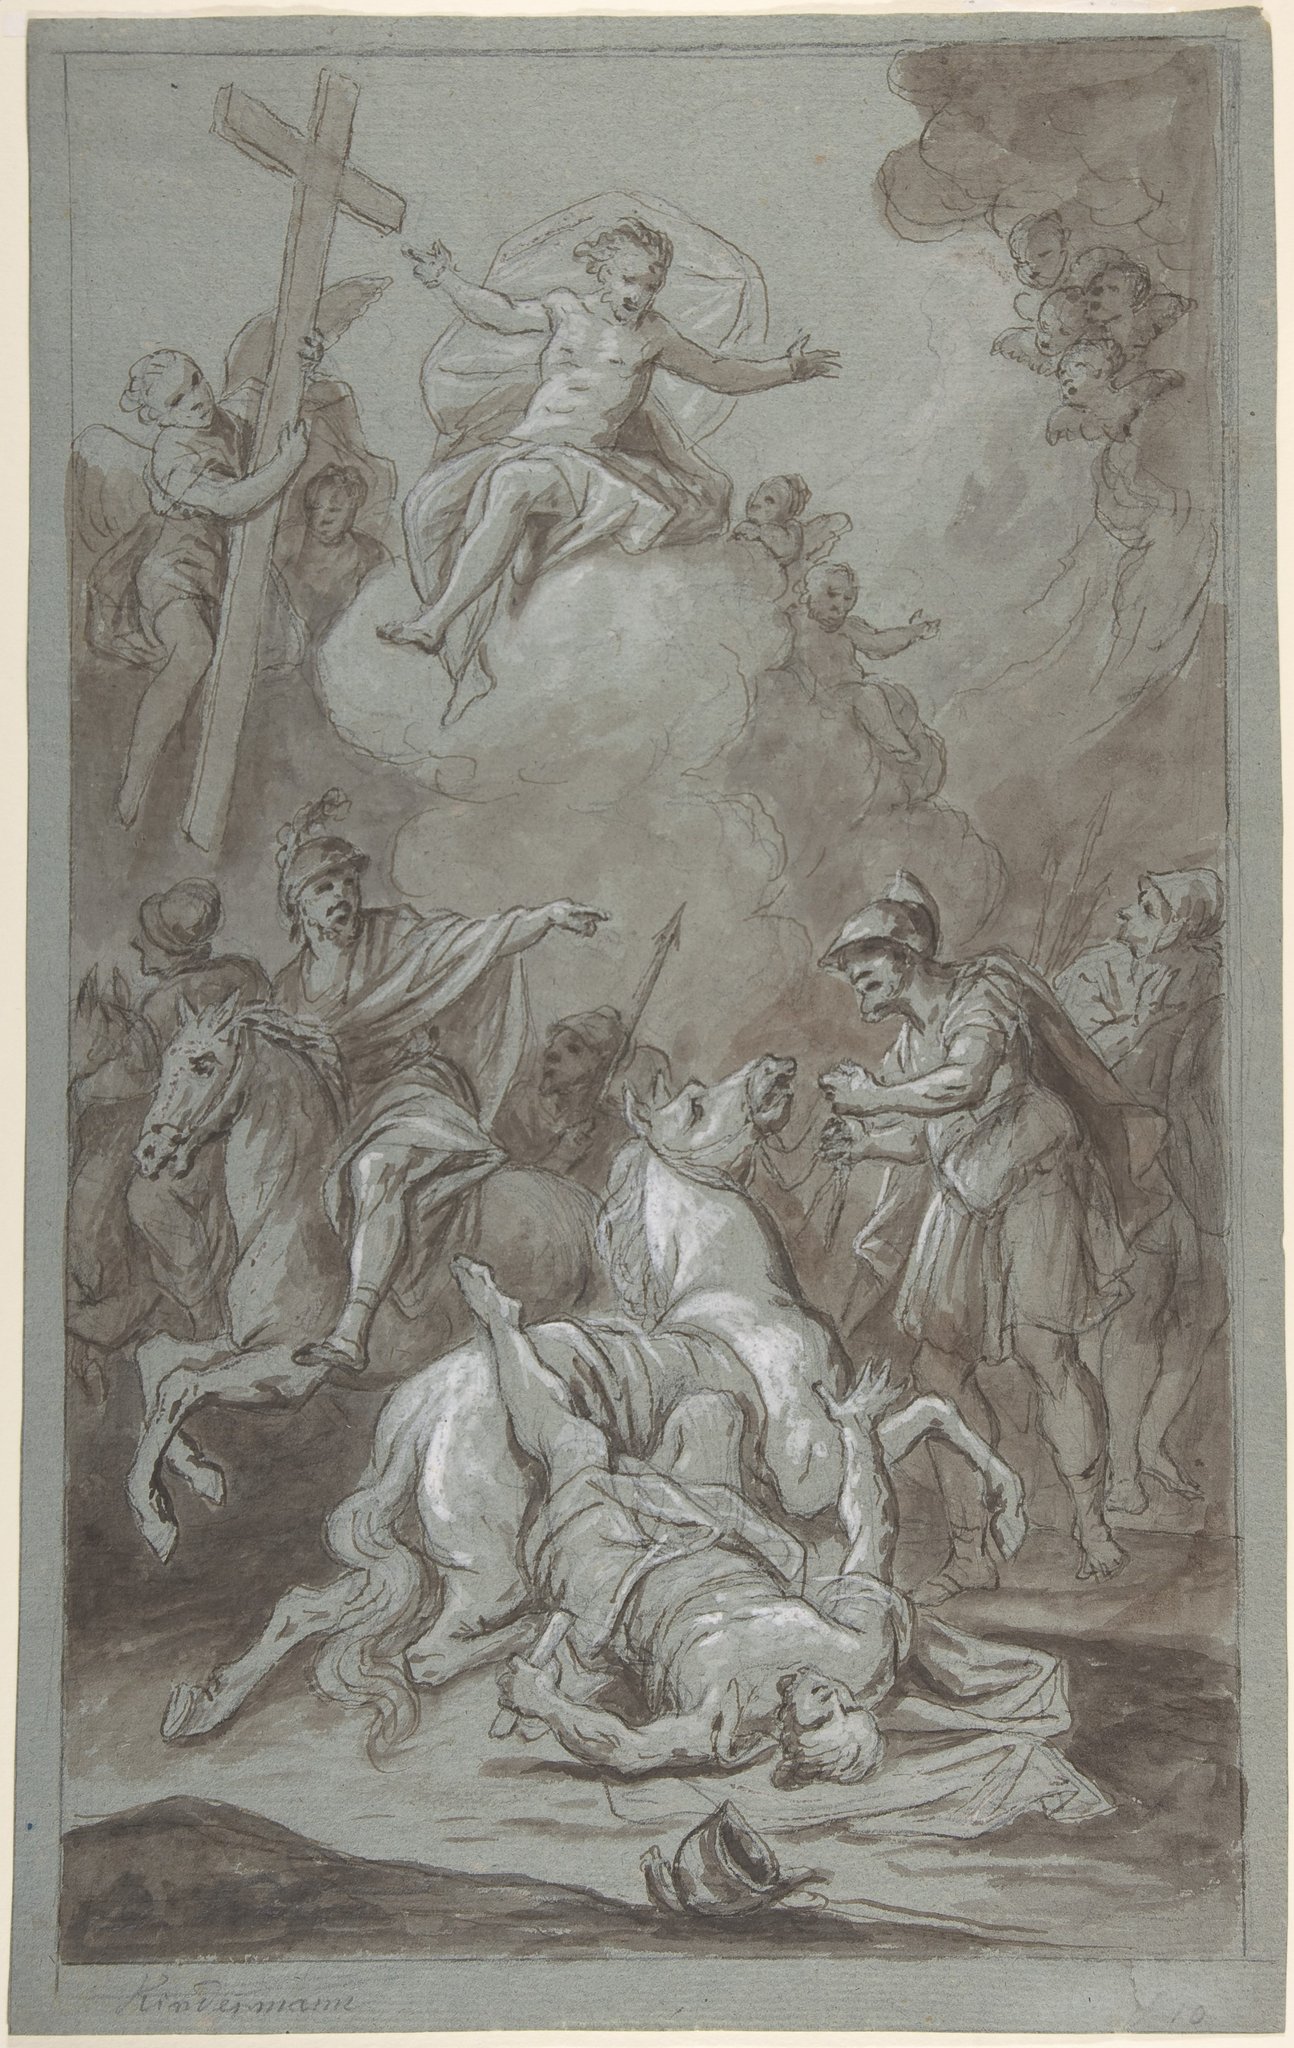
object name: drawing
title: The Conversion of St. Paul (recto); The Execution of the Prisoner (verso)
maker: dominik kindermann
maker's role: artist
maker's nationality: austrian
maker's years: 1739-1817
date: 1701-1833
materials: chalk, gouache, ink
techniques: brush, heightening, pen, wash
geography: germany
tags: prisoners,men,horses,saint paul,cross